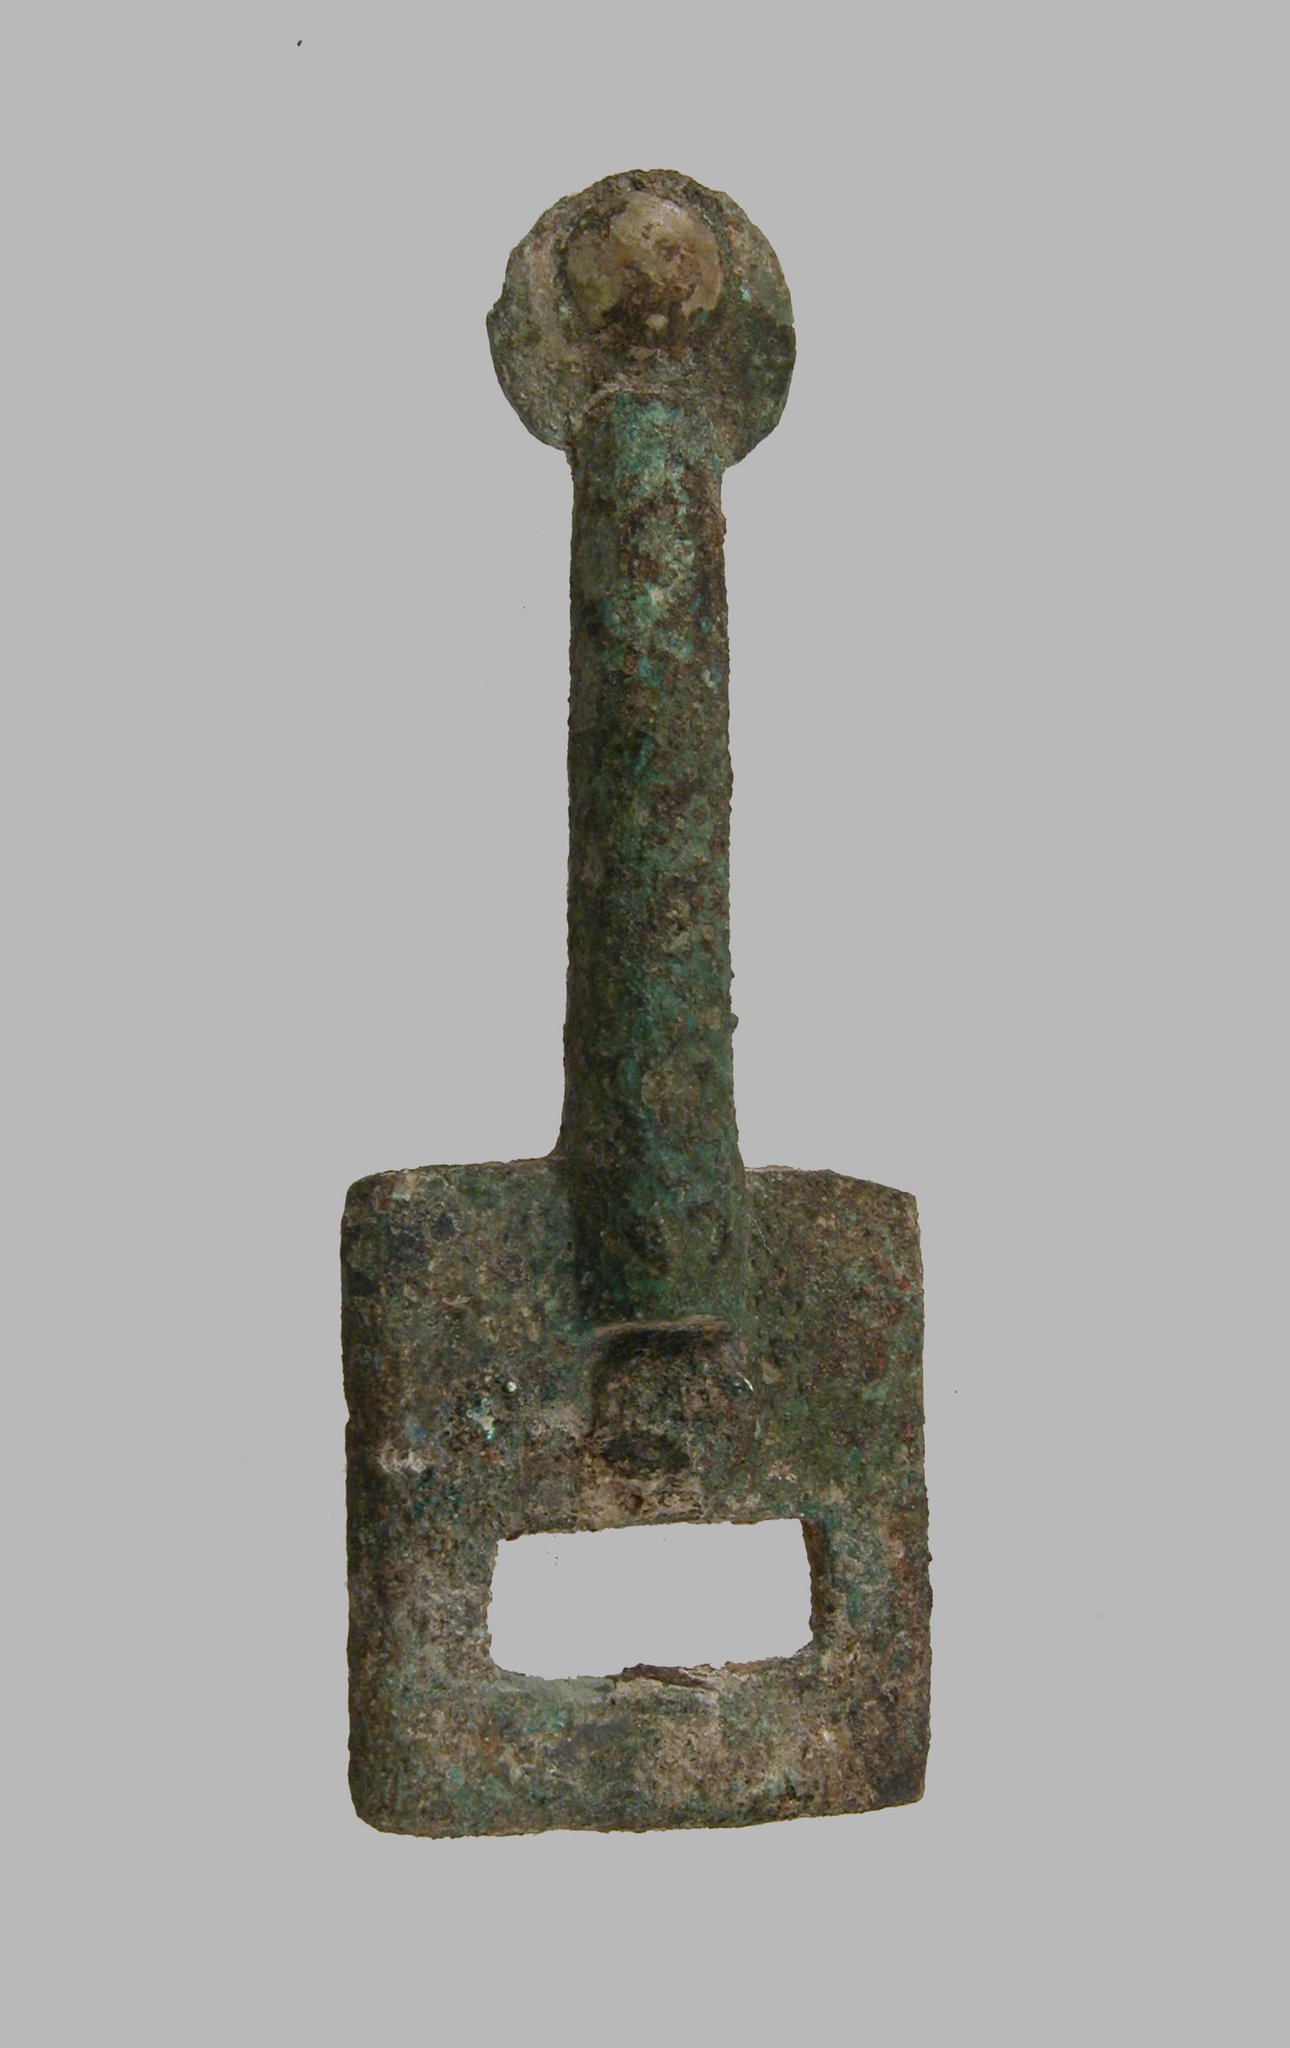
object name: plaque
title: Rectangular Plaque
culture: frankish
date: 534-566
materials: copper alloy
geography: germany